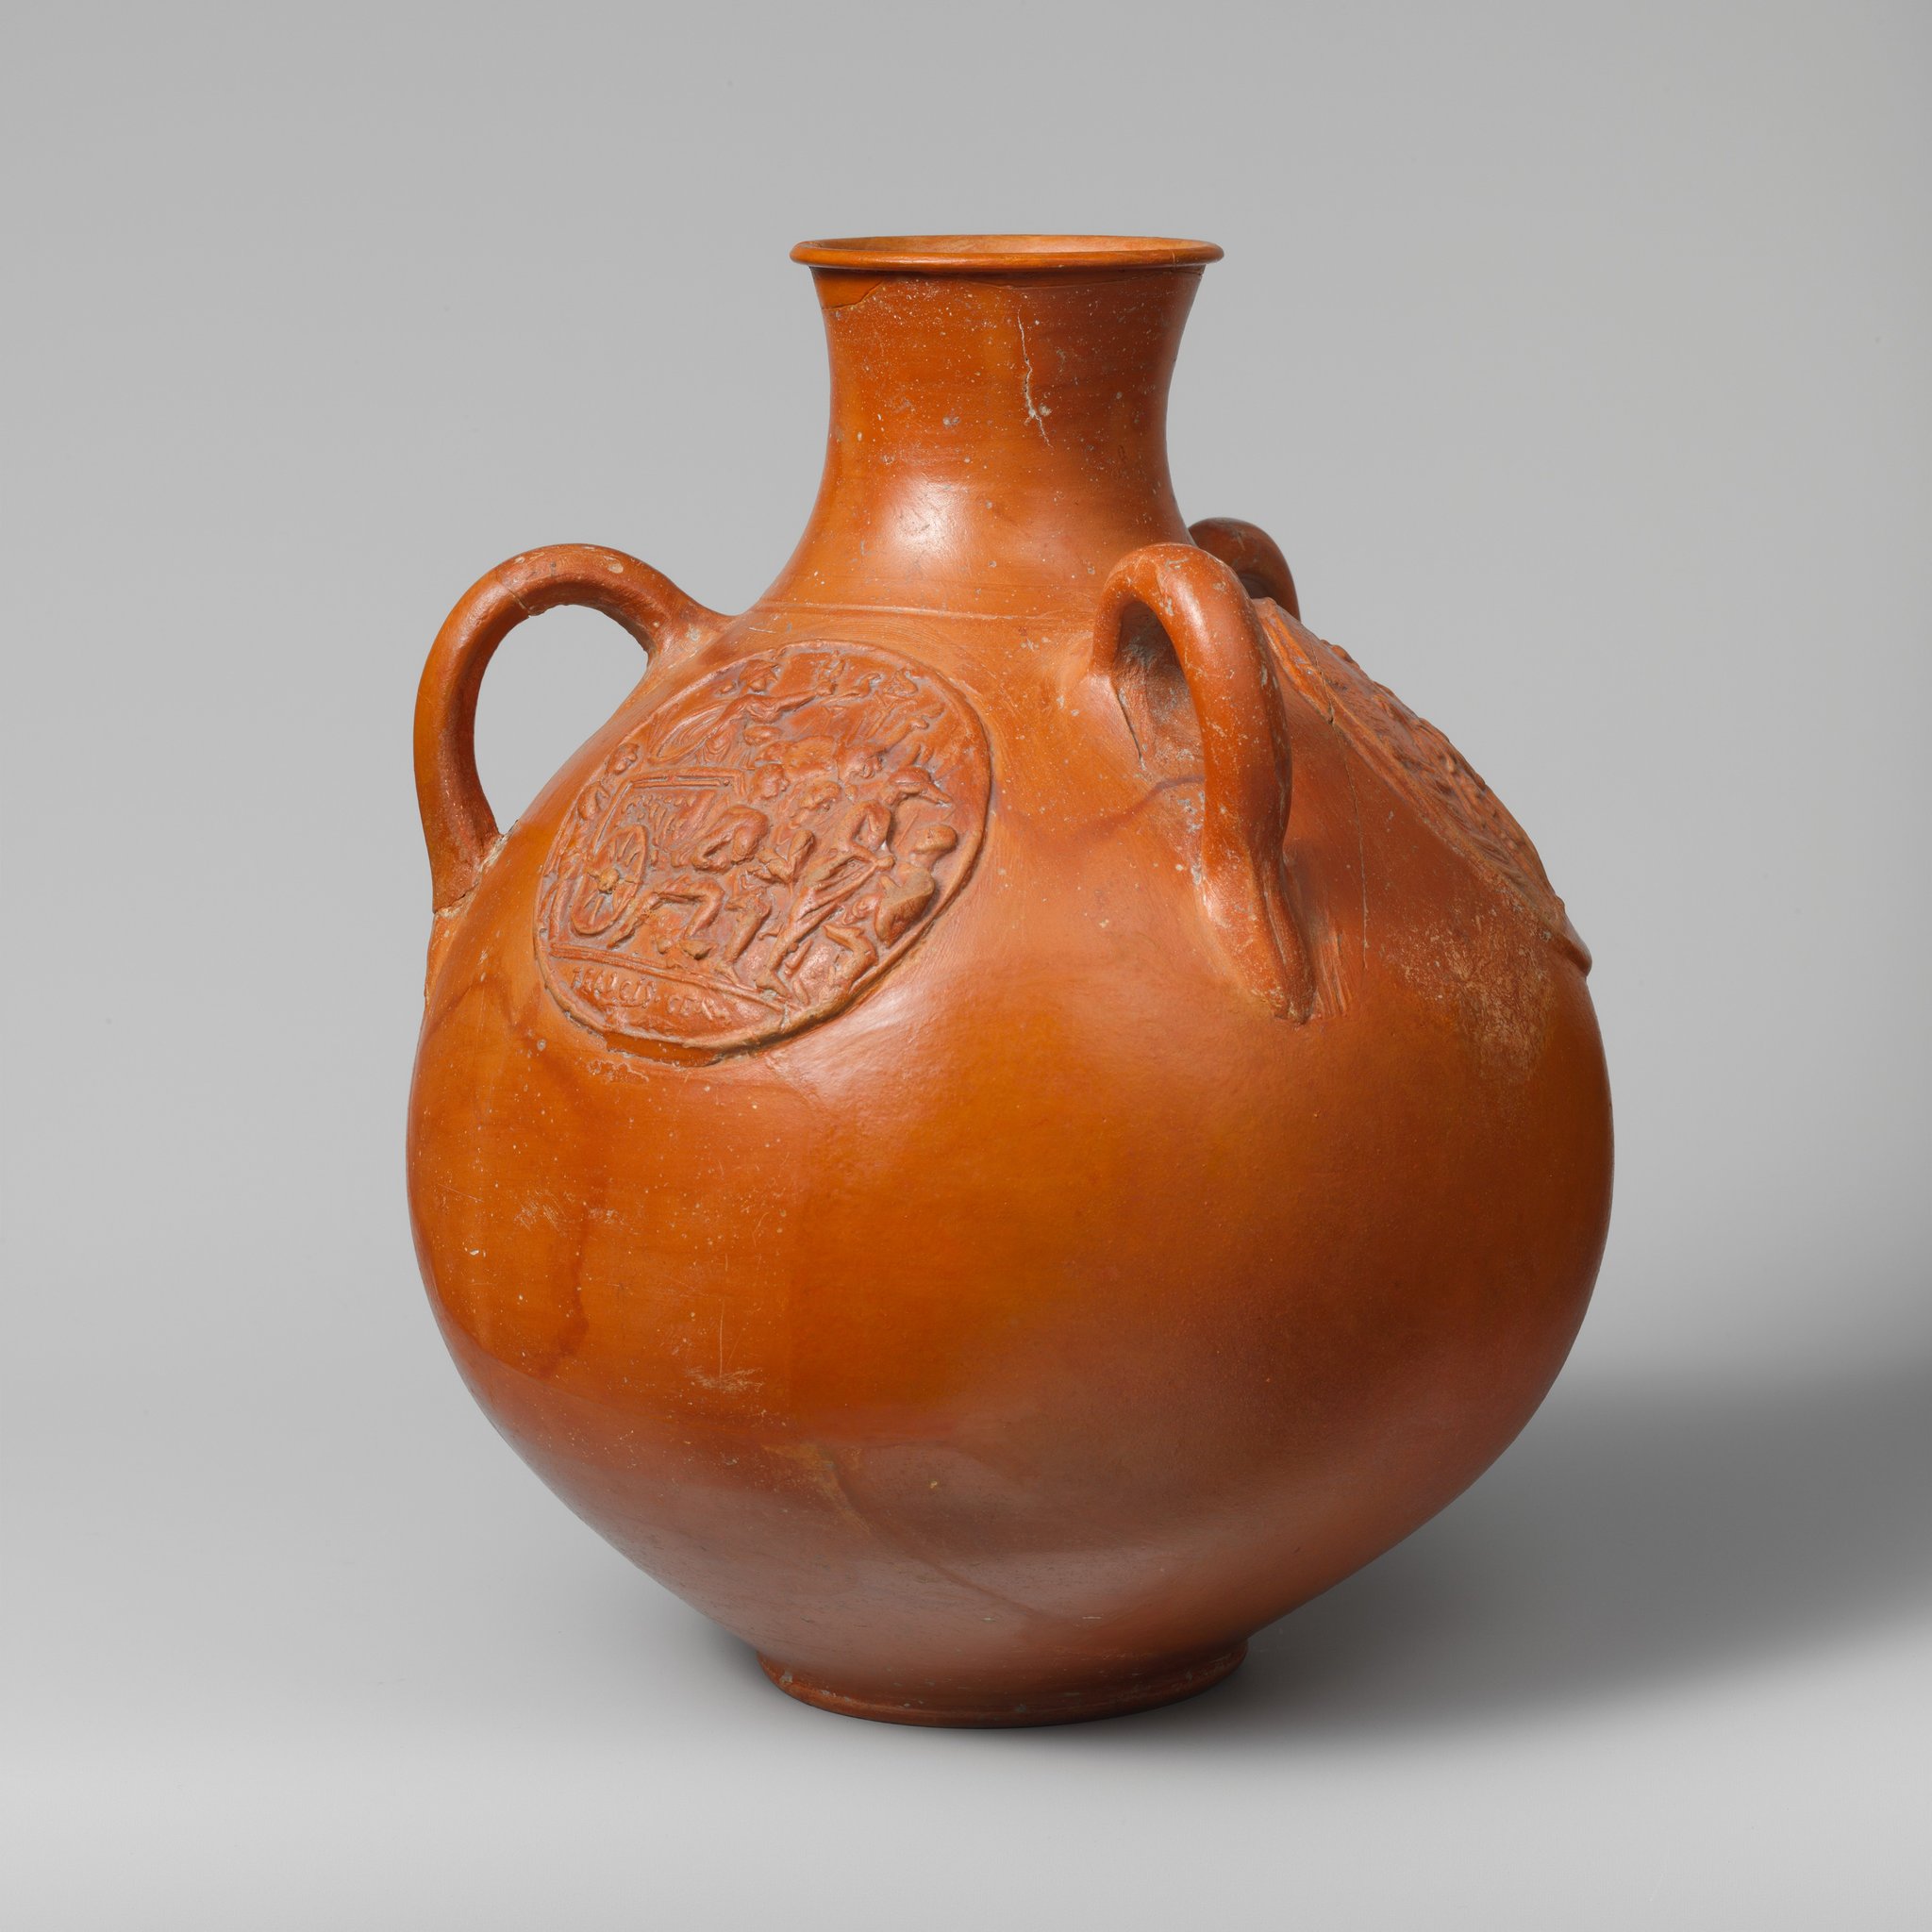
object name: jug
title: Three-handled jug with relief medallions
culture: roman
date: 167-233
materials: terracotta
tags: men,isis,carts